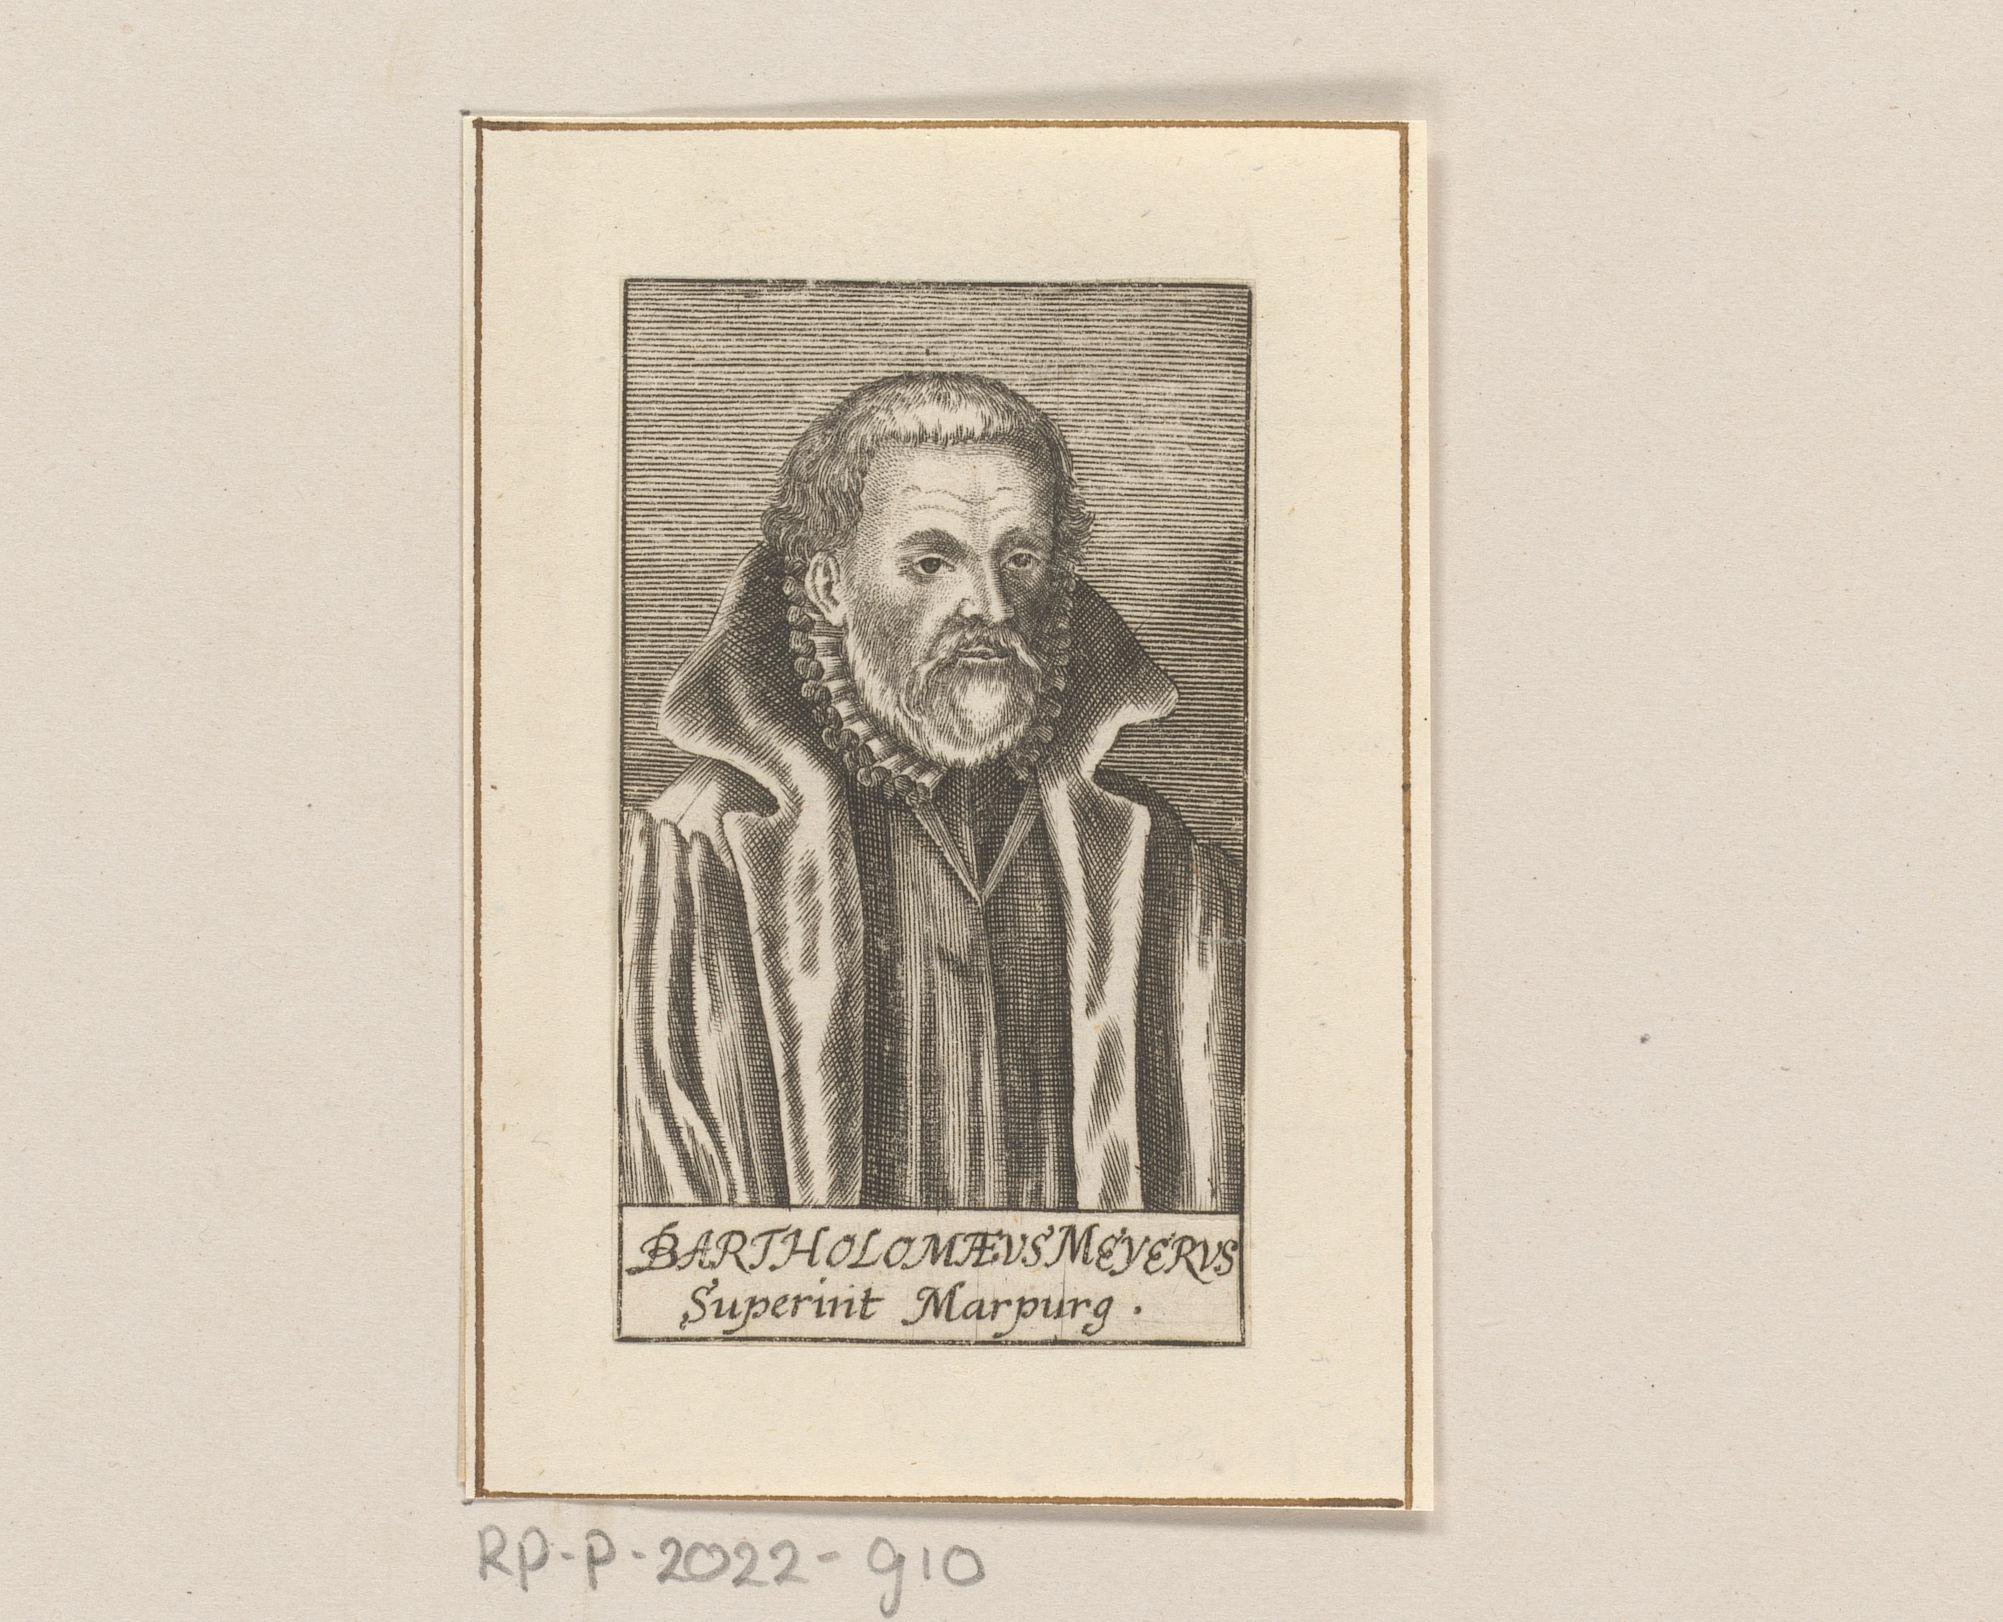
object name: print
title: Portret van Bartholomäus Meyer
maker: Anonymous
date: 1688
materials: paper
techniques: engraving, snipping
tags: theologian, historical persons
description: Prent maakt deel uit van een grotere prent die later is verknipt. Prent waarschijnlijk uit: Freher, Paul. Theatrum virorum eruditione clarorum. Neurenberg: Johann Hoffmann, 1688